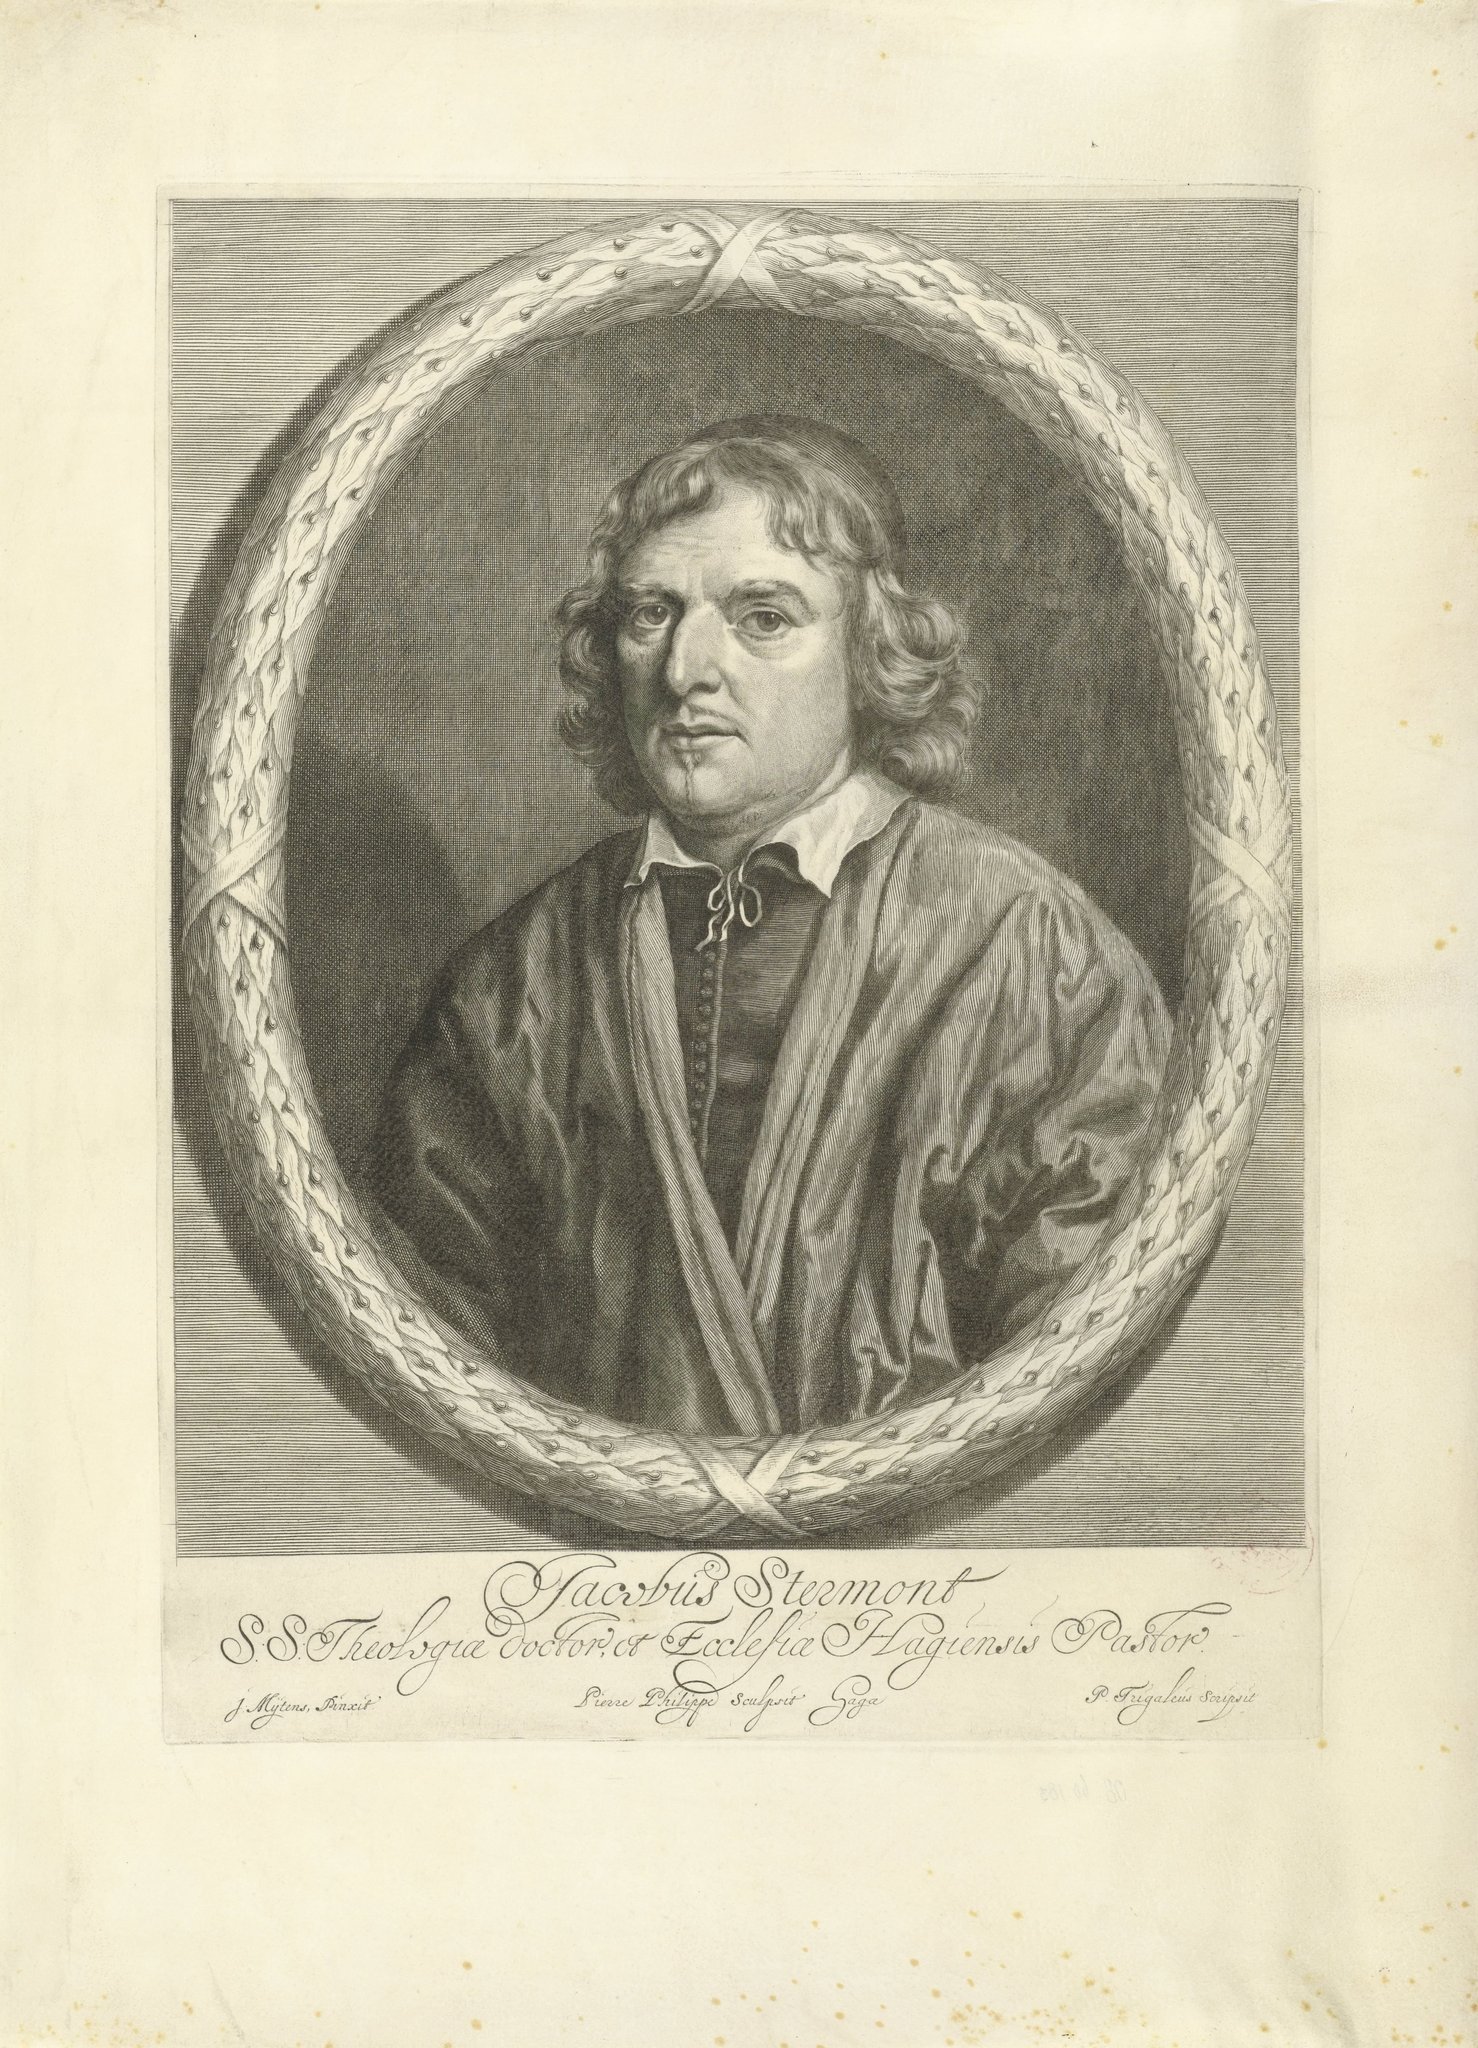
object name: print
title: Portret van Jacobus Stermont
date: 1635-1702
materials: paper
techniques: engraving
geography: the hague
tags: predikant, jacobus stermont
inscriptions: collector's mark: Lugt 240, collector's mark: Lugt 2228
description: Portret van Jacobus Stermont, predikant te Leiderdorp (1632), Rotterdam (1641) en 's Gravenhage (1649).